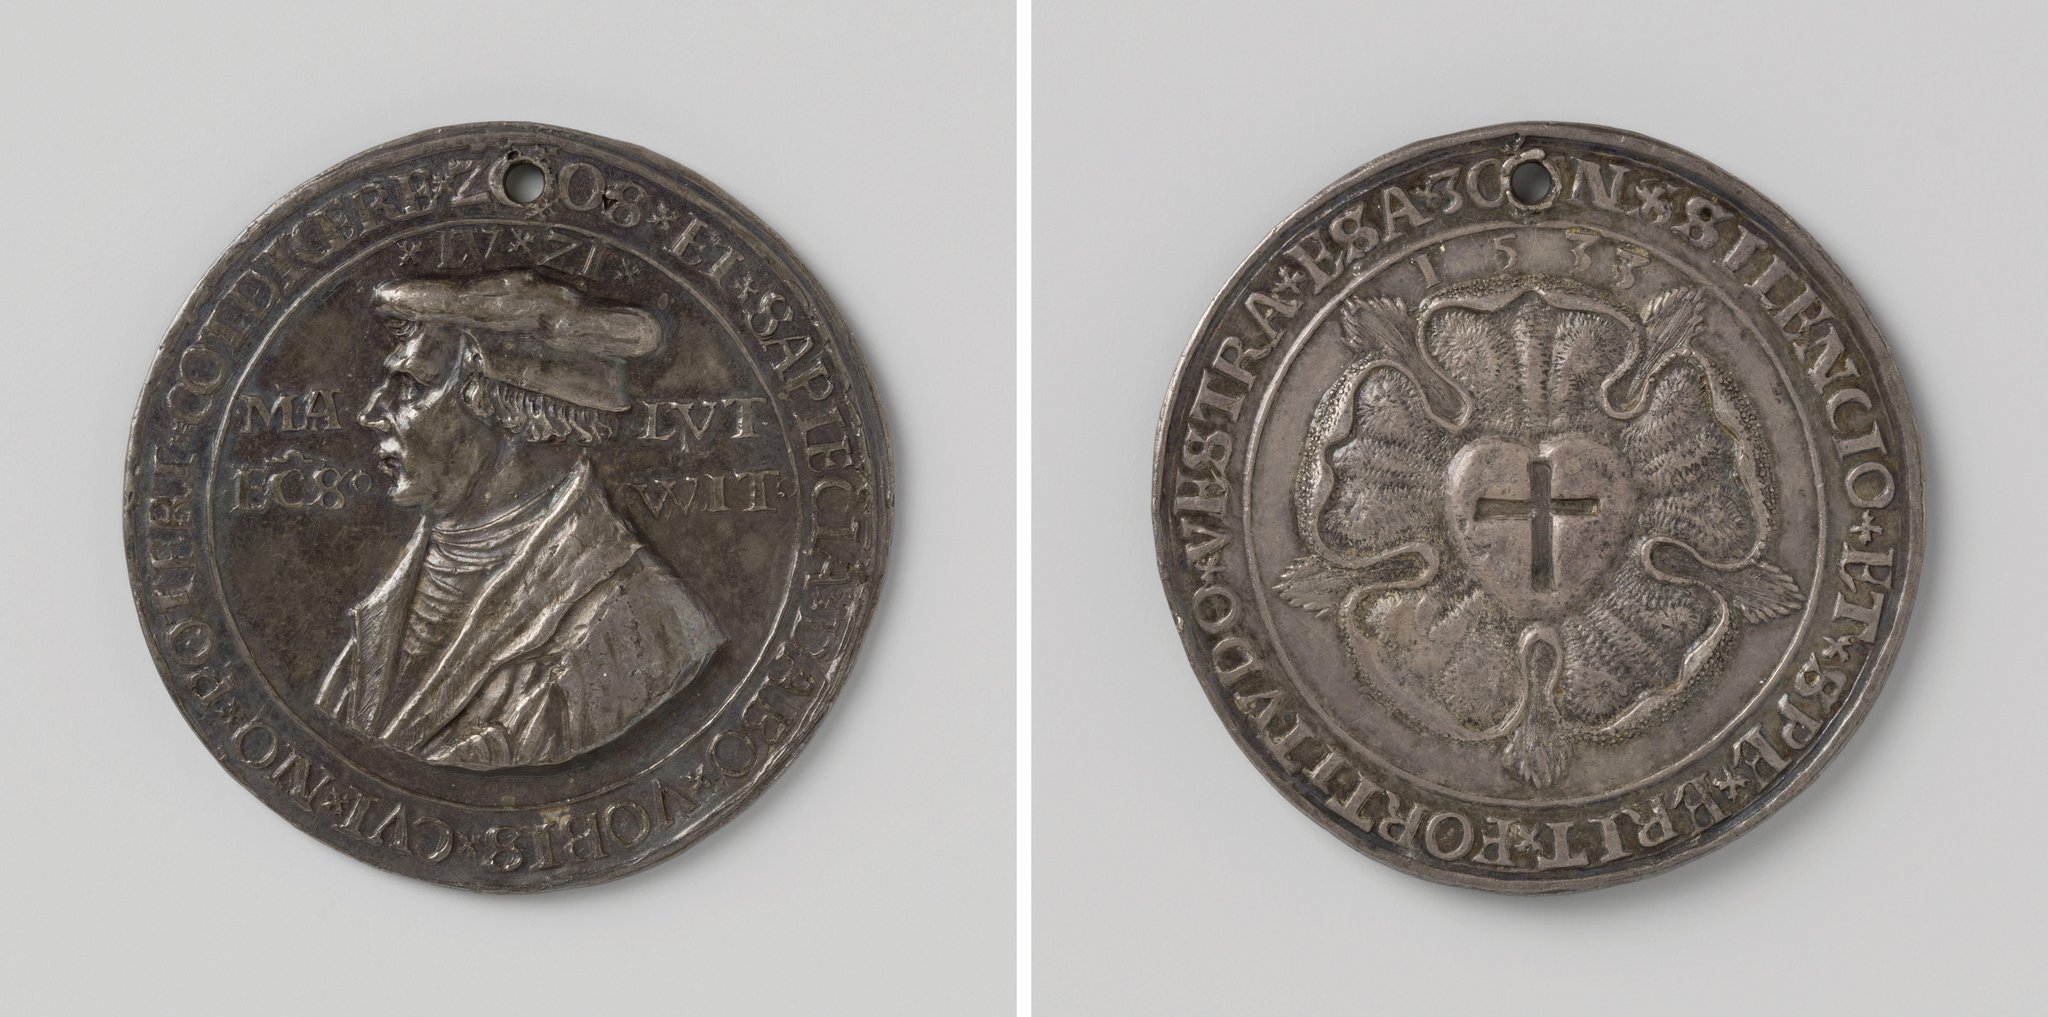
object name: history medal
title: Ter ere van Martin Luther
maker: michael hohenauer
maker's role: die cutter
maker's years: 1530-1558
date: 1533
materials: silver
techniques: striking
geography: prague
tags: priest, martin luther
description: Zilveren penning. Voorzijde: borststuk man tussen en onder opschriften, binnen omschrift. Keerzijde: hart met kruis op een roos onder jaartal binnen omschrift